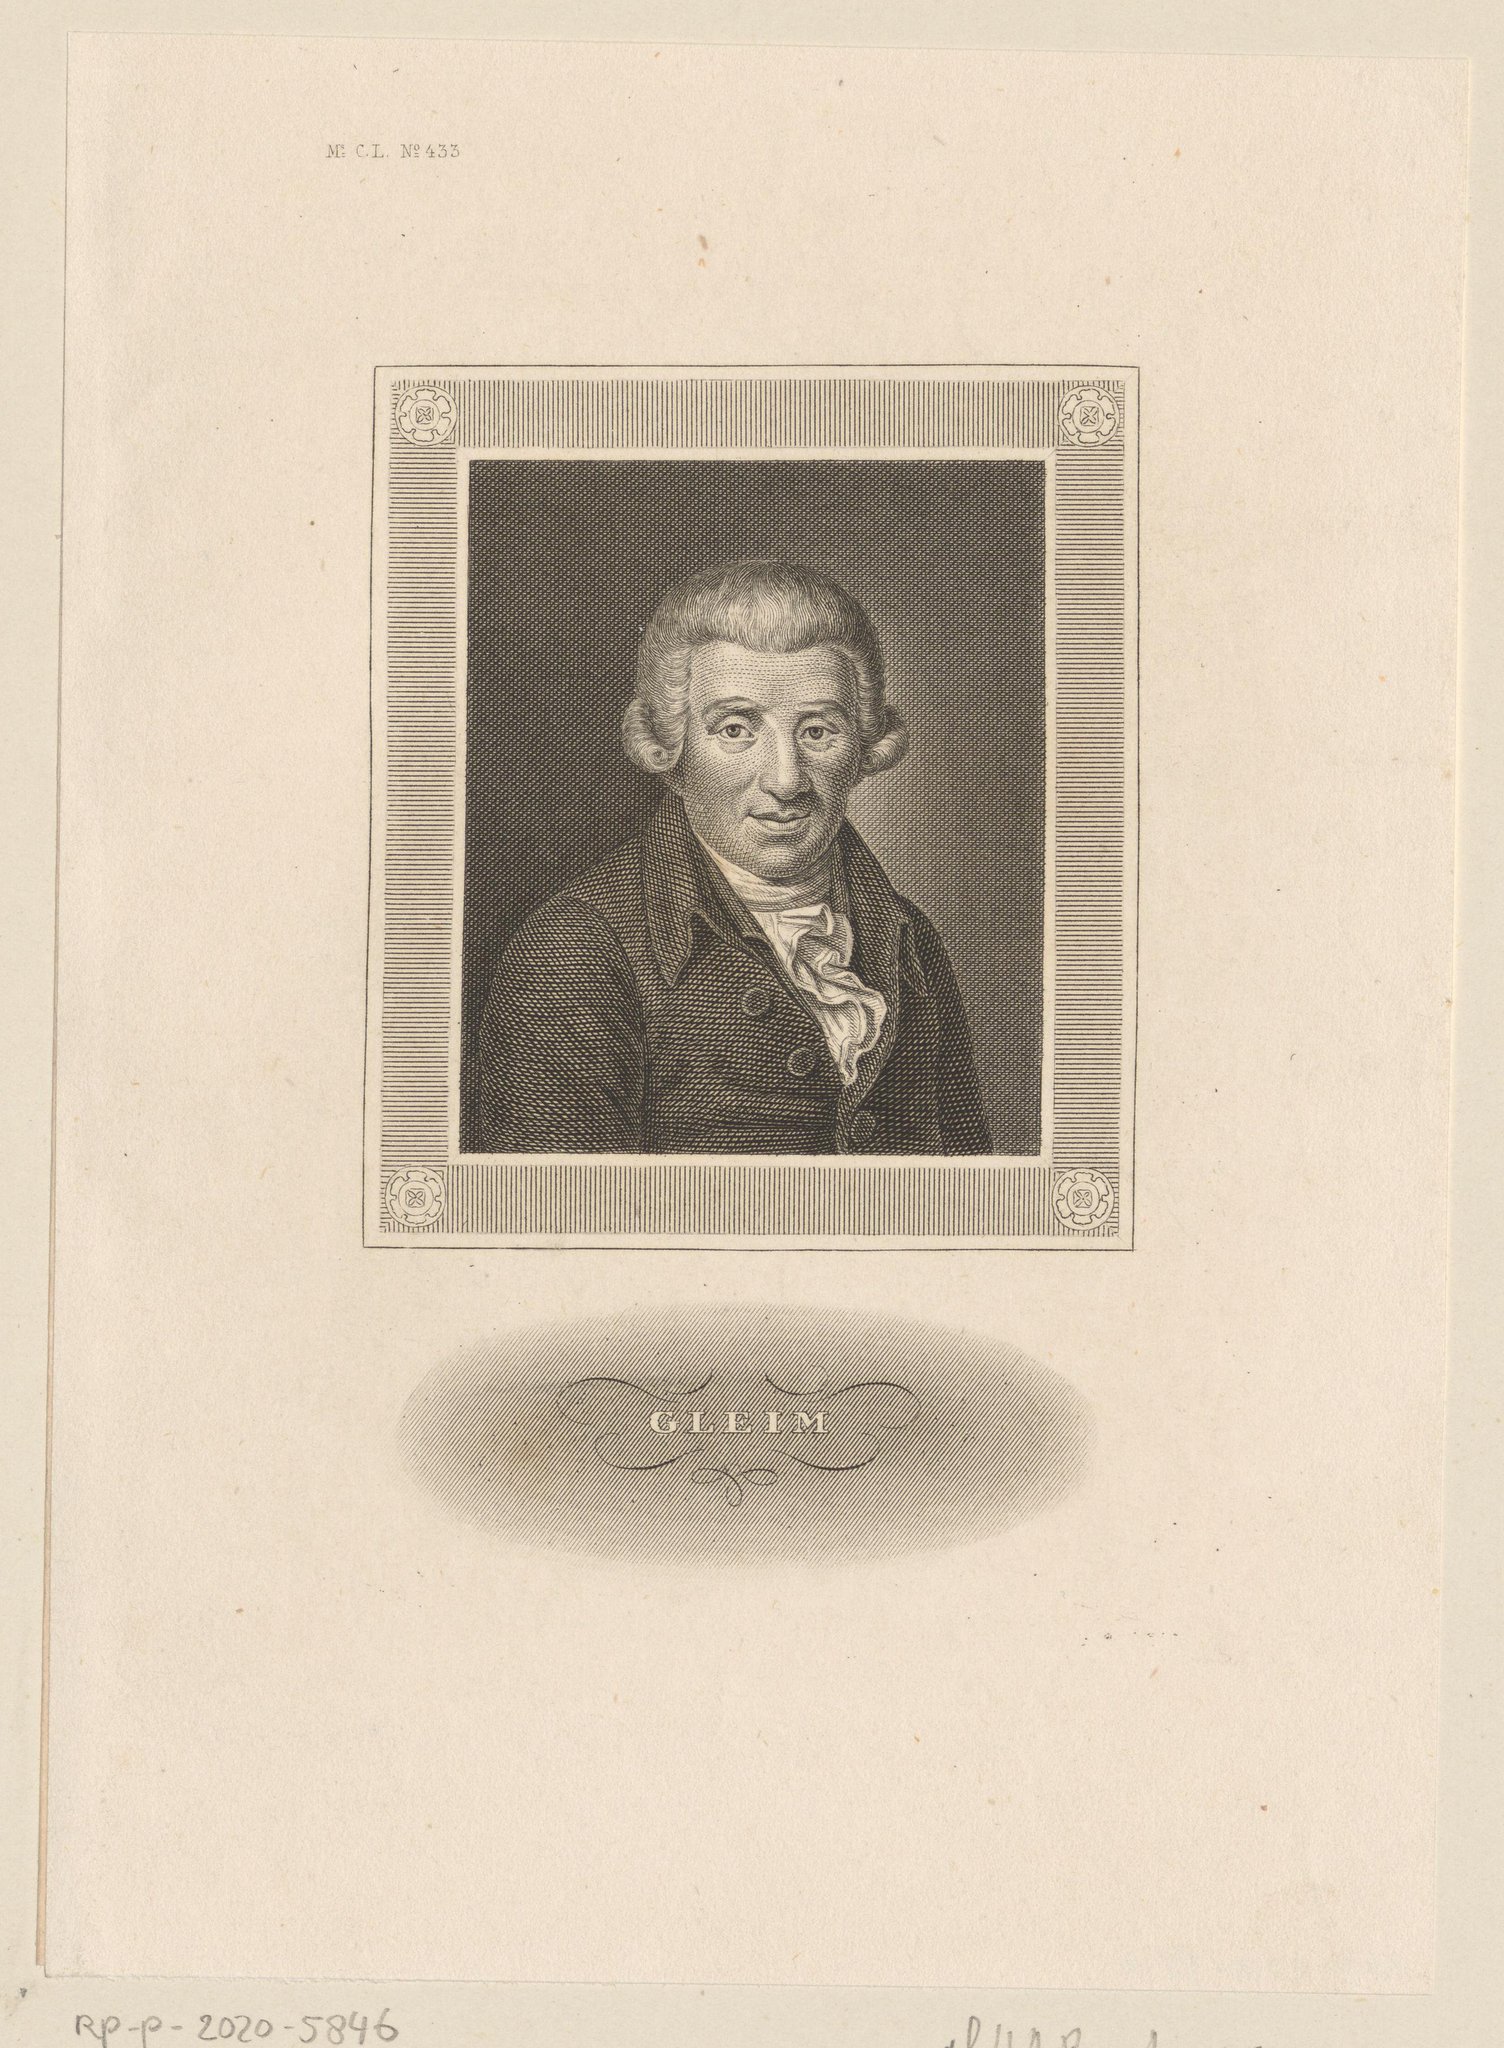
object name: book illustration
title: Portret van Johann Wilhelm Ludwig Gleim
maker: gustav zumpe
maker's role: print maker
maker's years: 1793-1854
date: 1828-1861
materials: paper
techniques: engraving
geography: hildburghausen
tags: theologian, historical persons, portrait of a writer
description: Prent uit: Meyer, Joseph. [Neues] Conversations-Lexikon für die gebildeten Stände. Hildburghausen: Bibliographisches Institut, [1828-1861].